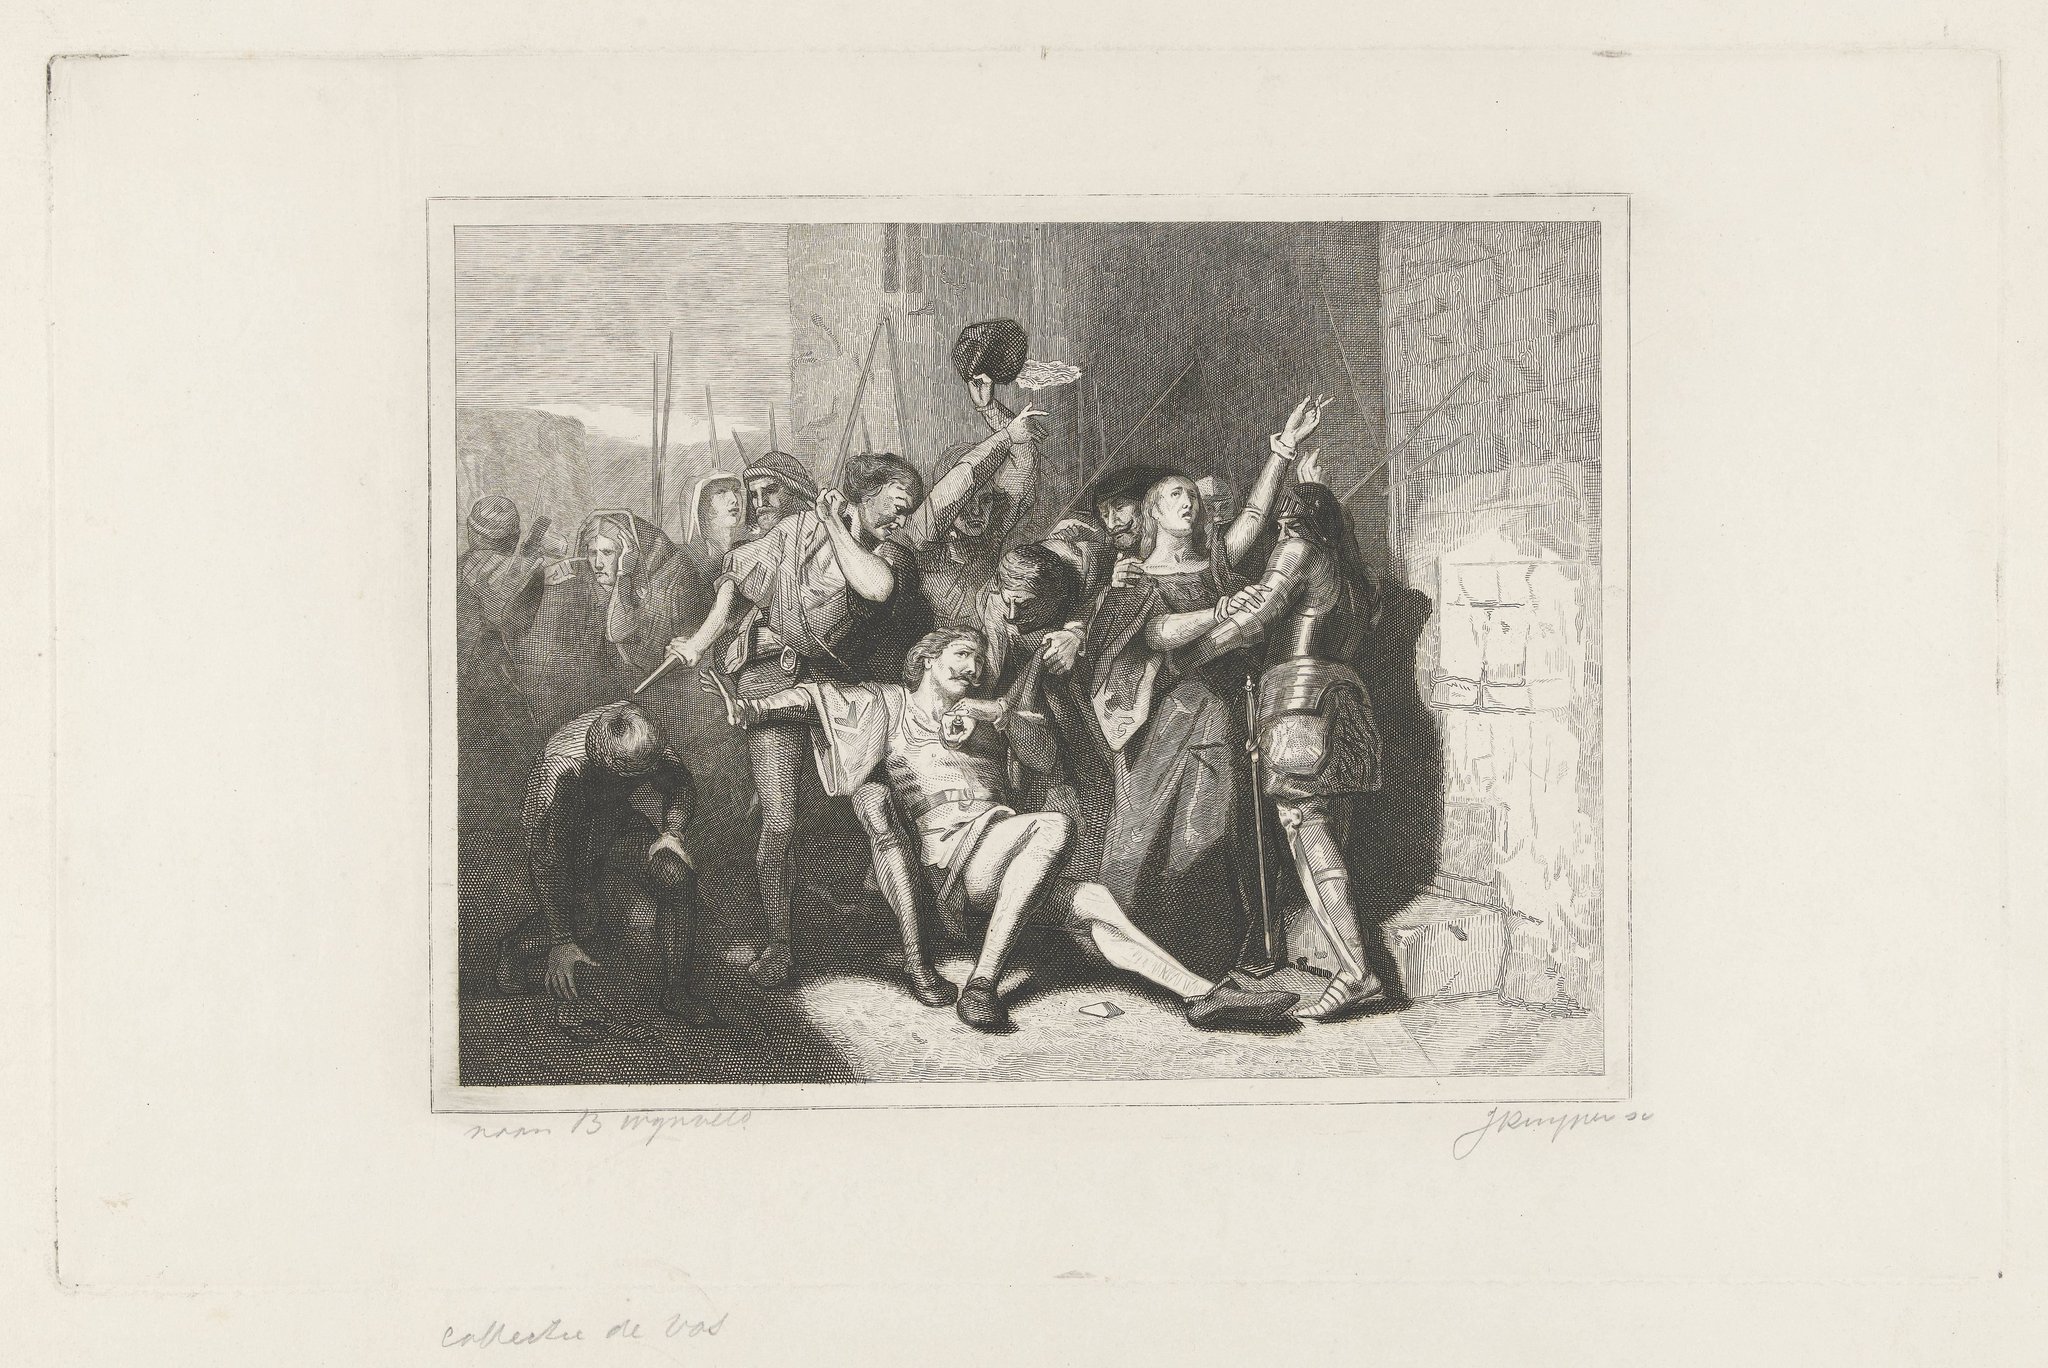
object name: print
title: Aanval voor de slotpoort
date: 1860-1870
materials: paper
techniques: engraving, etching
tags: surprise attack (stratagem)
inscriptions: inscription: ‘naar B Wijnveld Collectie de [...]’, inscription: ‘J Kuyper’, collector's mark: Lugt 2228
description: Een man en vrouw worden voor de poort van een slot aangevallen door soldaten en burgers.